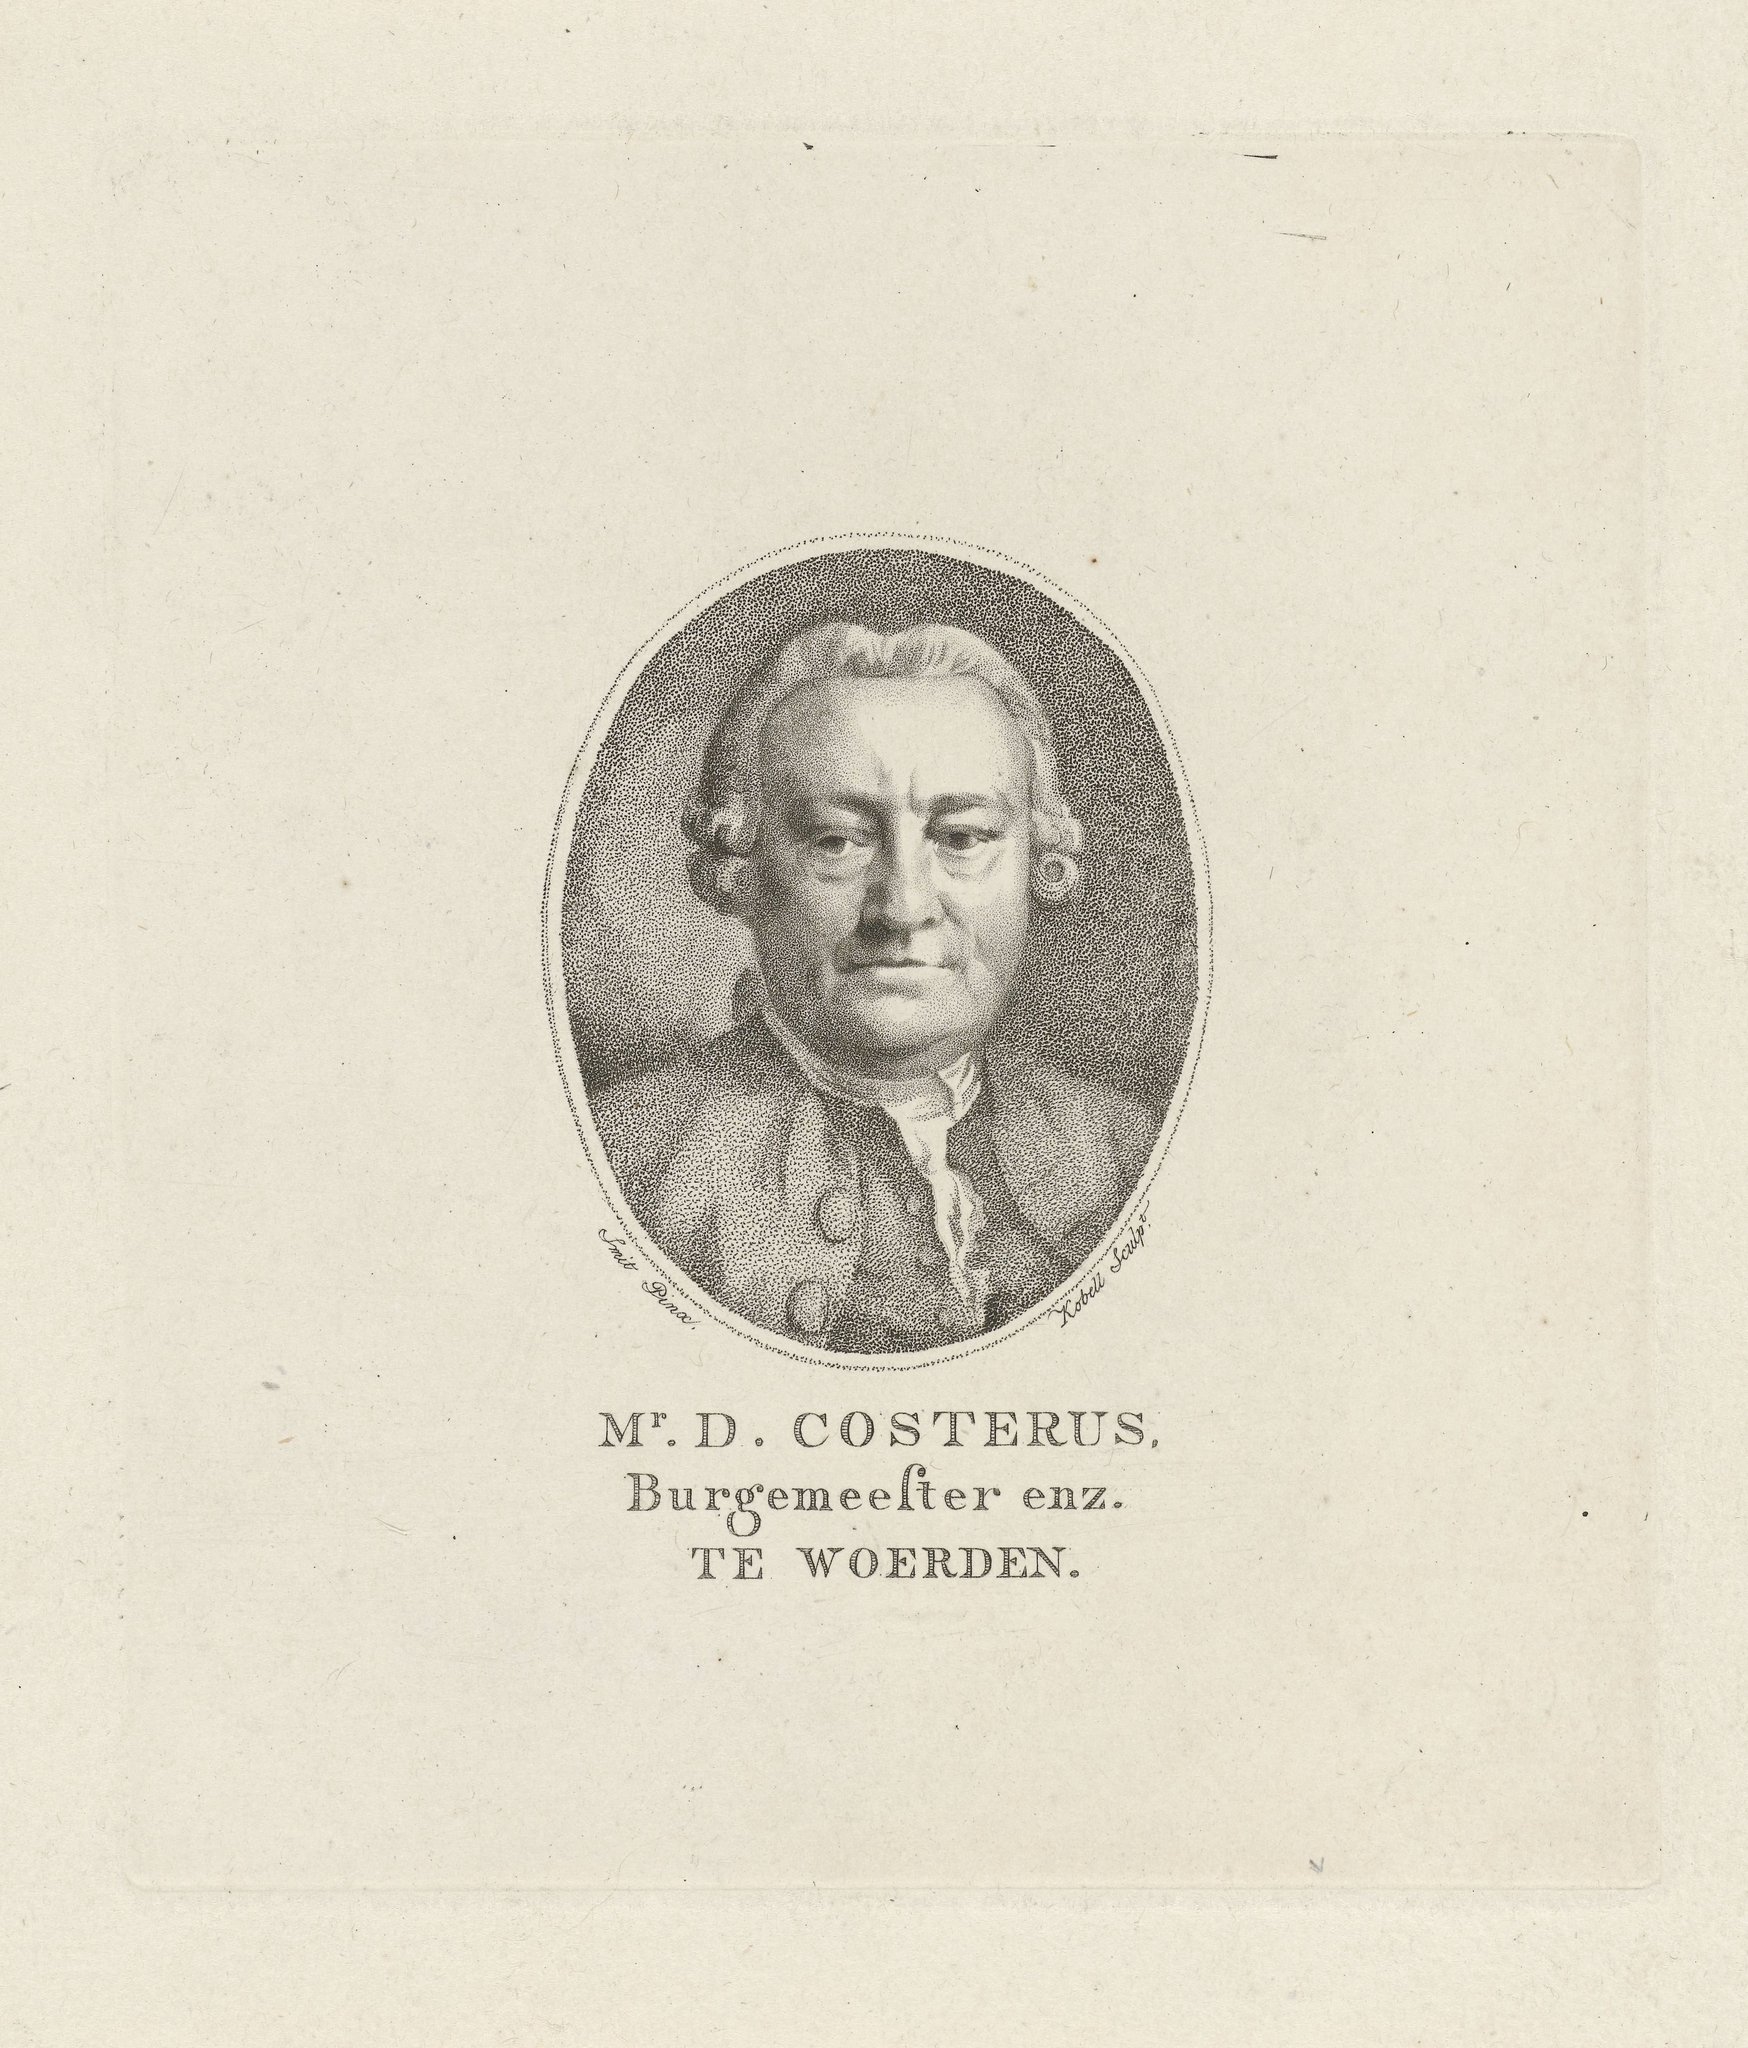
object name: print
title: Mr. D. Costerus Burgemeester enz. te Woerden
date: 1787-1833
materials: paper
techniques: etching, engraving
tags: dominicus costerus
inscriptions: collector's mark: Lugt 2228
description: Portretbuste van Dominicus Costerus, schout en baljuw in Woerden en schrijver.